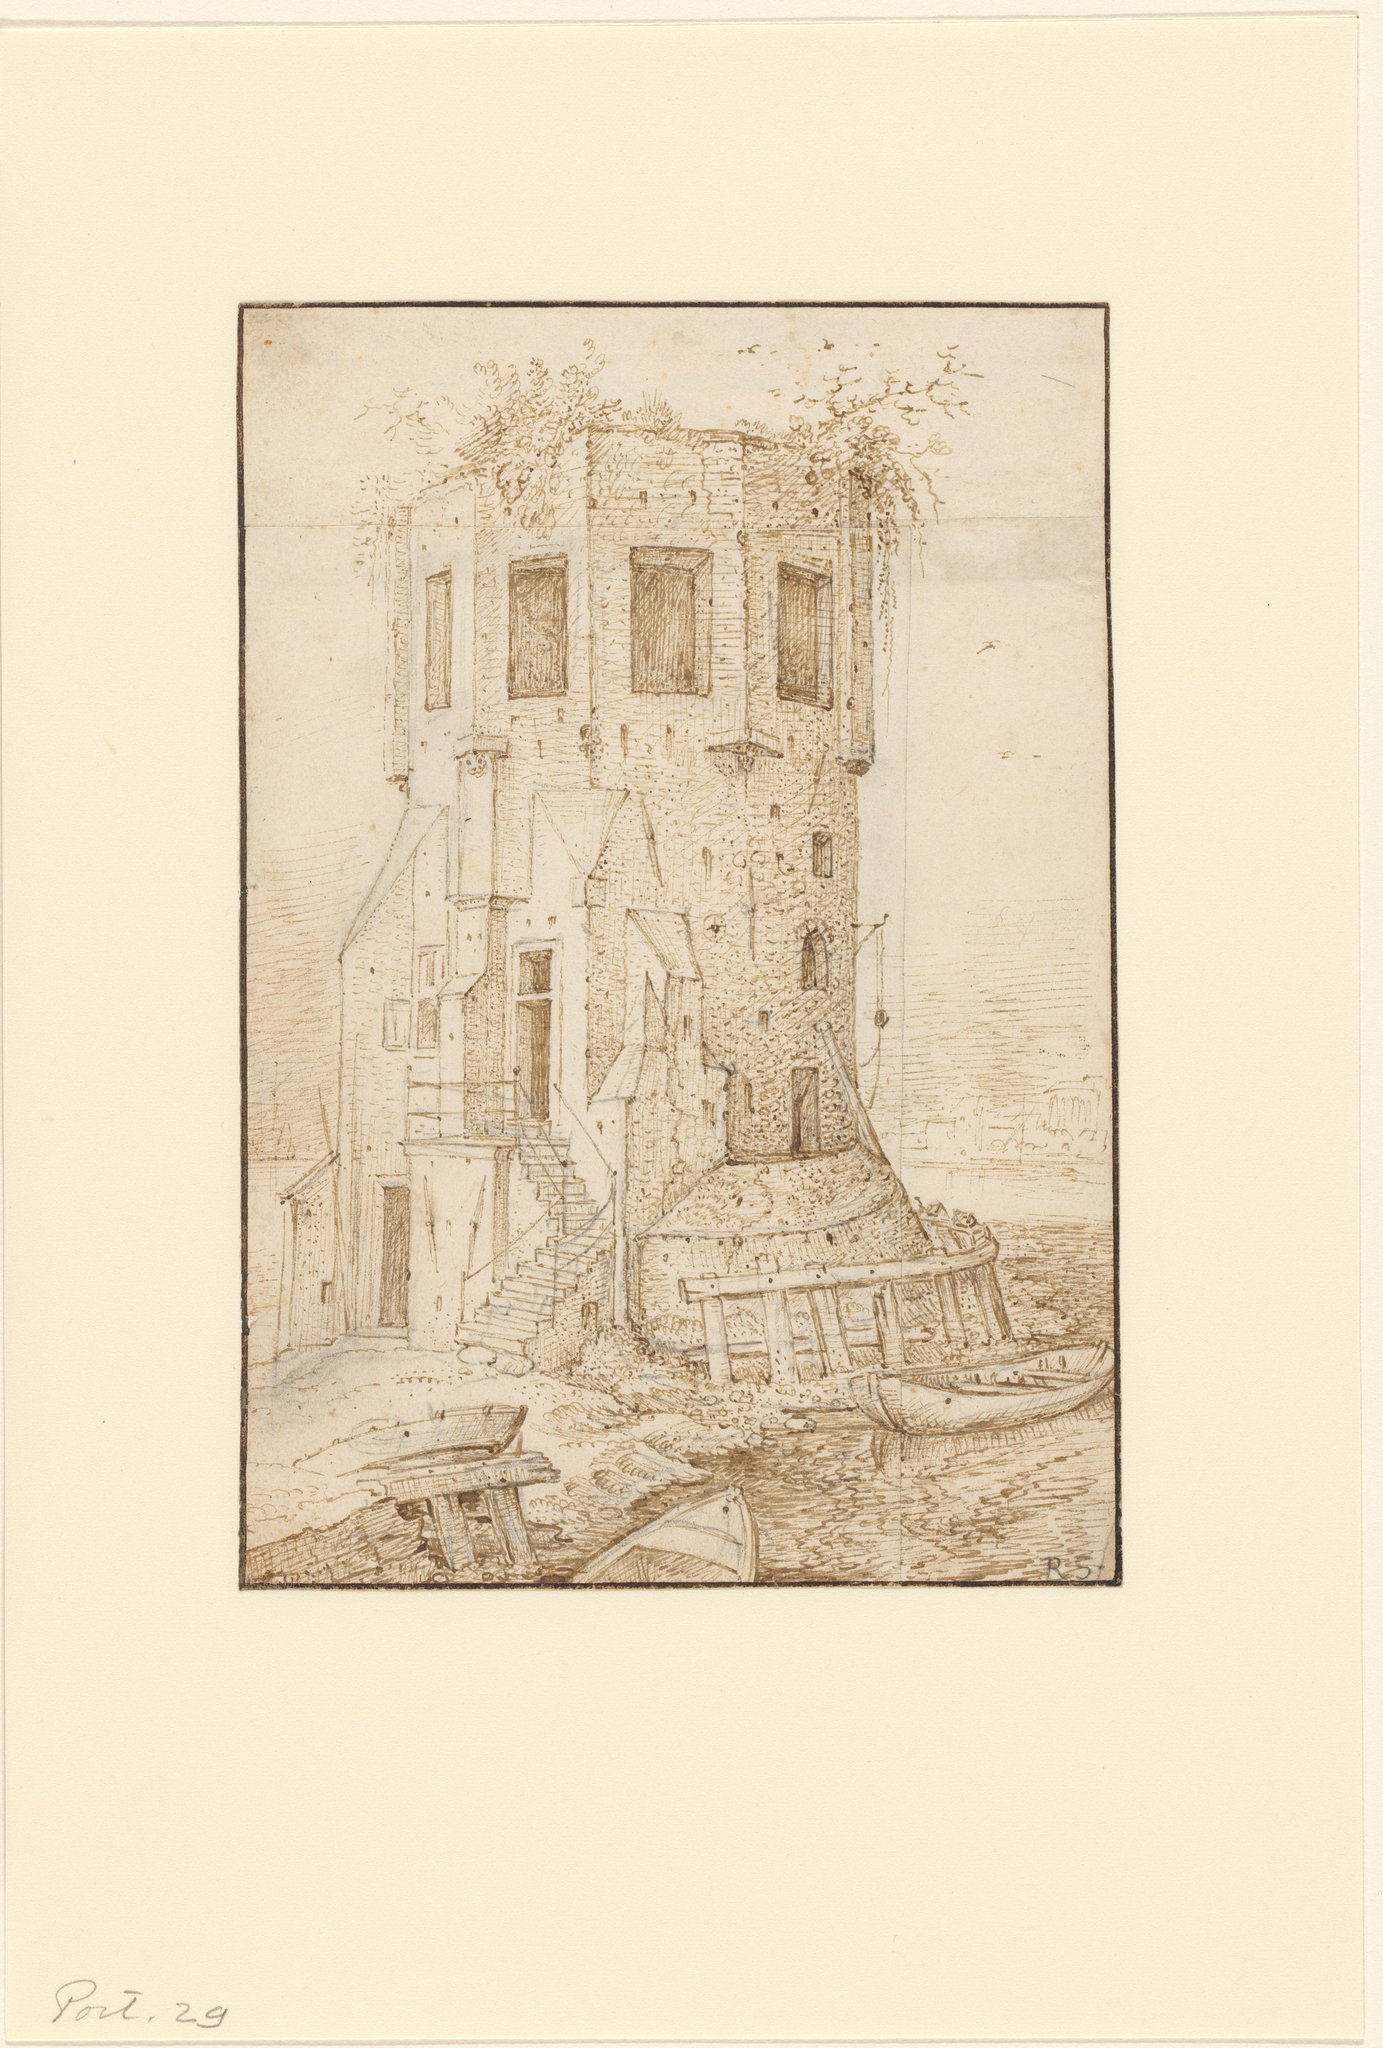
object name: print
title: Gezicht op de Munttoren te Amsterdam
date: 1693-1694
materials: paper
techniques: engraving, etching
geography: amsterdam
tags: tower, clock tower ~ monumental adornment, rowing-boat, canoe, etc., canals, waters (in city) (+ city(-scape) with figures, staffage)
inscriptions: collector's mark: Lugt 1641b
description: Prent mogelijk uit: Commelin, Casparus. Beschryvinge van Amsterdam (…). Amsterdam: Abraham Wolfgang, Gillis Janssonius van Waesberge of Johannes Janssonius van Waesberge, Hendrick Boom of weduwe Dirk Boom, Abraham van Sanderen en Rembertus Goethals, 1693, dl. 2. Of uit: Commelin, Casparus. Beschryvinge van Amsterdam (…). Amsterdam: weduwe Aart Dircksz. Oossaan, 1694, dl. 2.